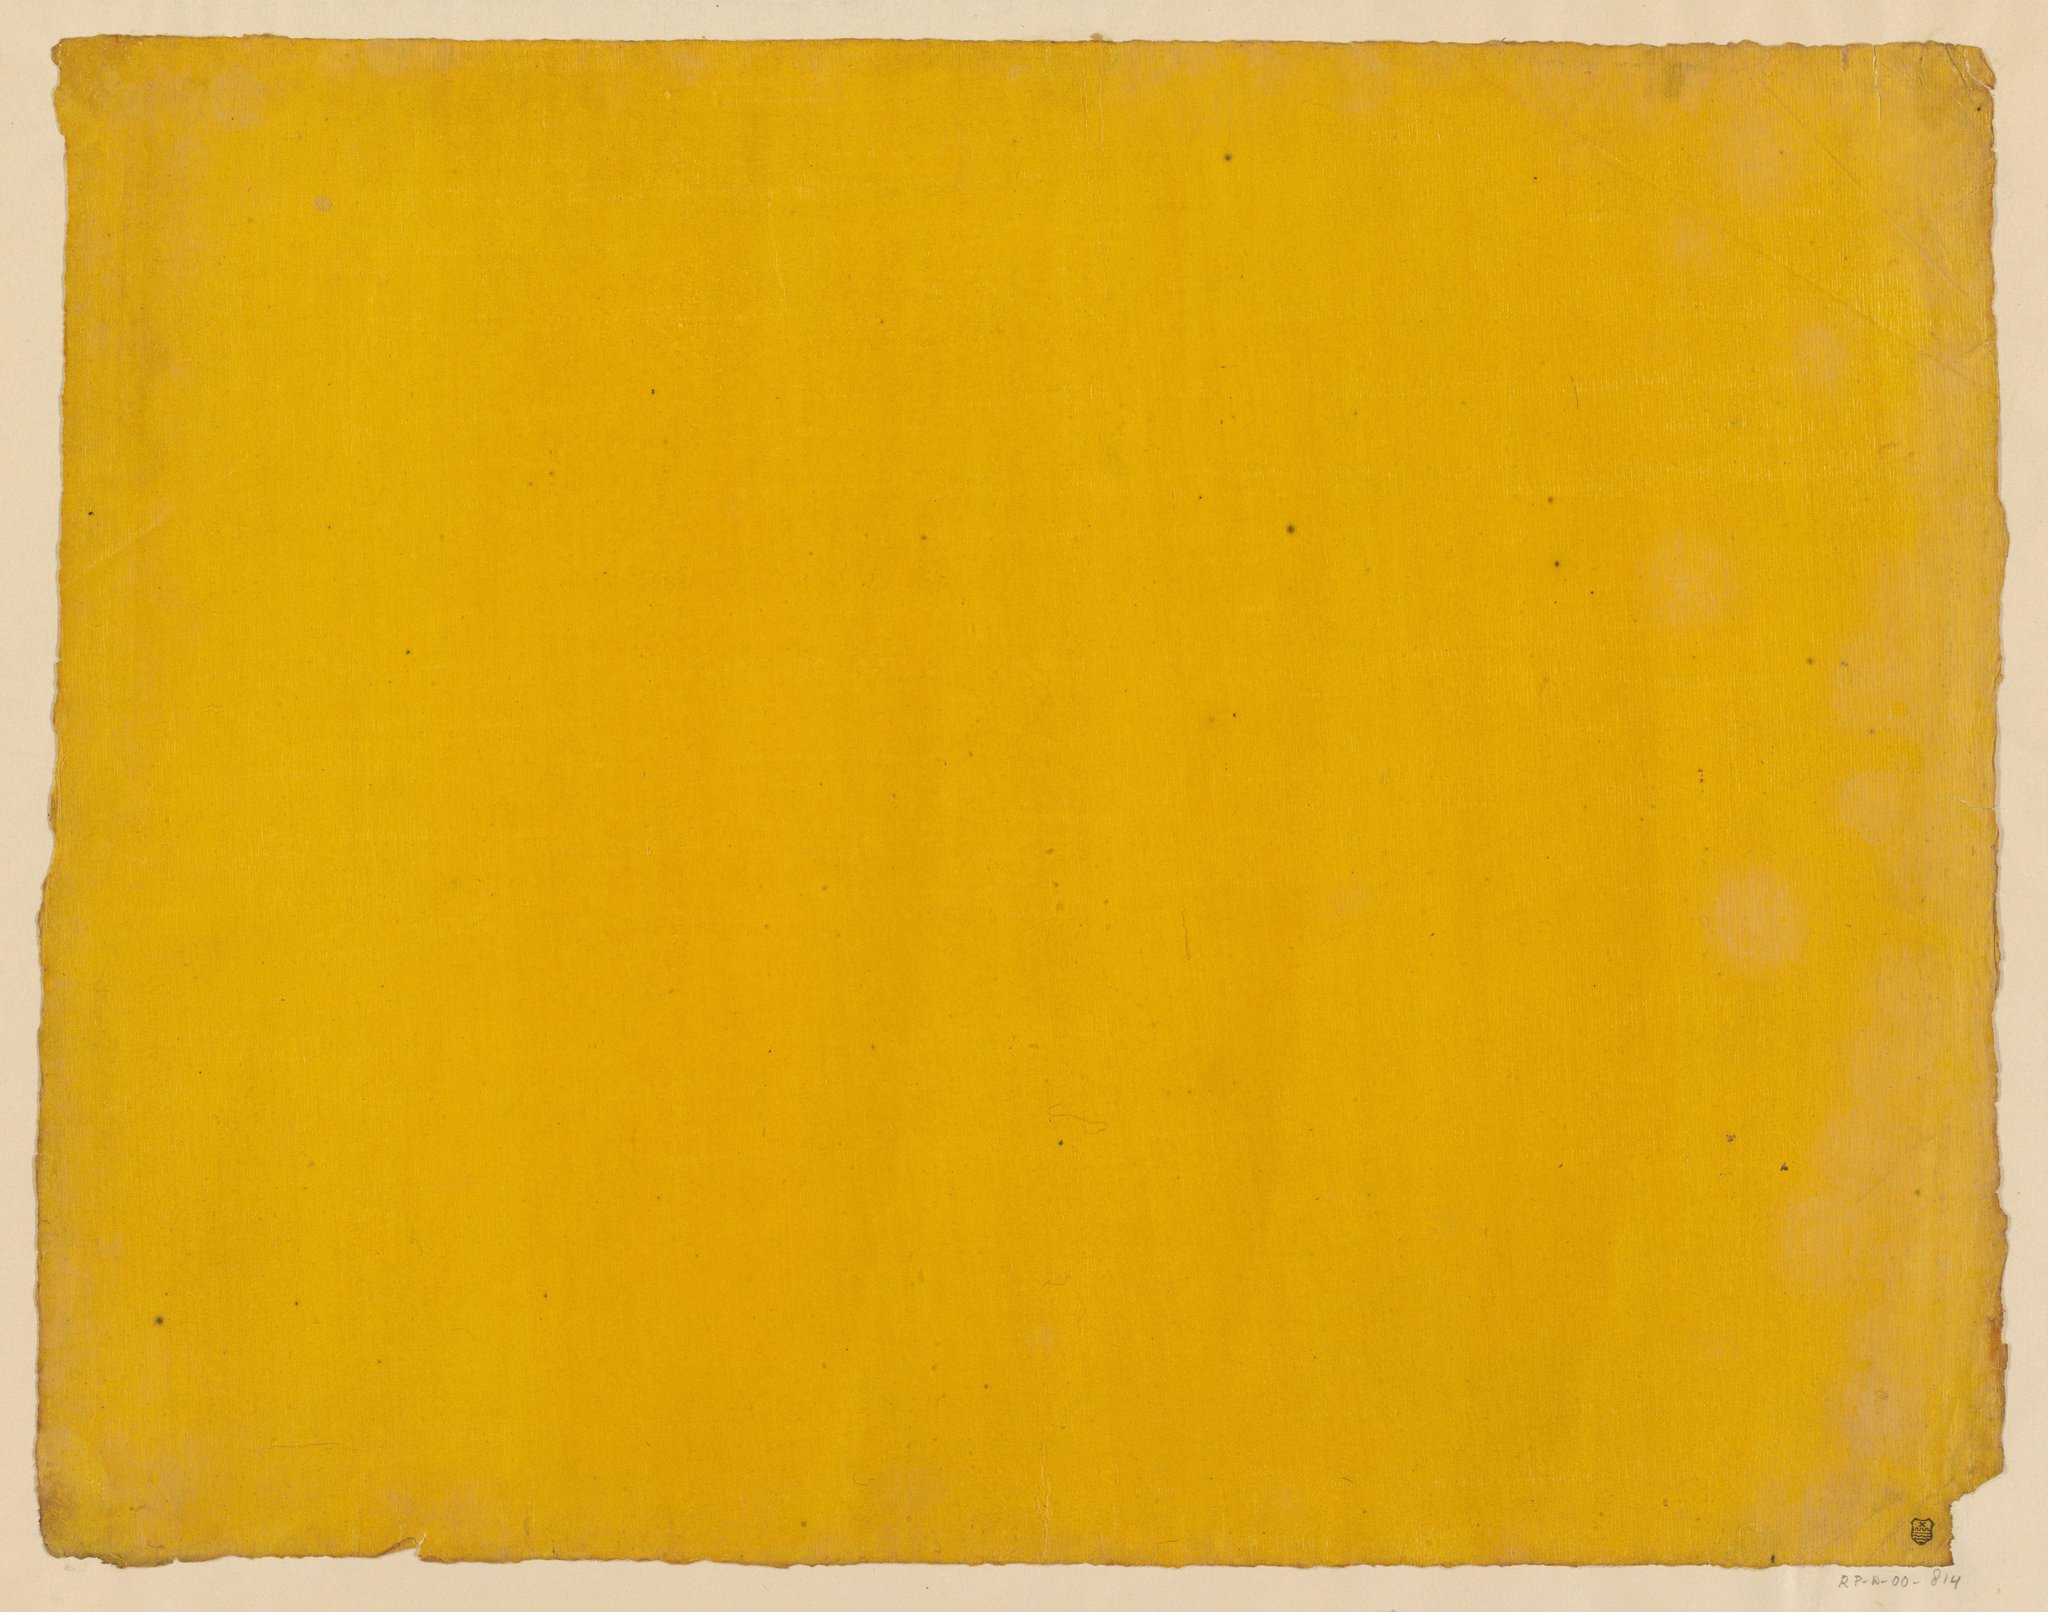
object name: decorated paper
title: Effen geel papier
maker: Anonymous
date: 1800-1900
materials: lacquer, paint, paper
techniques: hand coloring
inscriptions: collector's mark: Lugt 2760